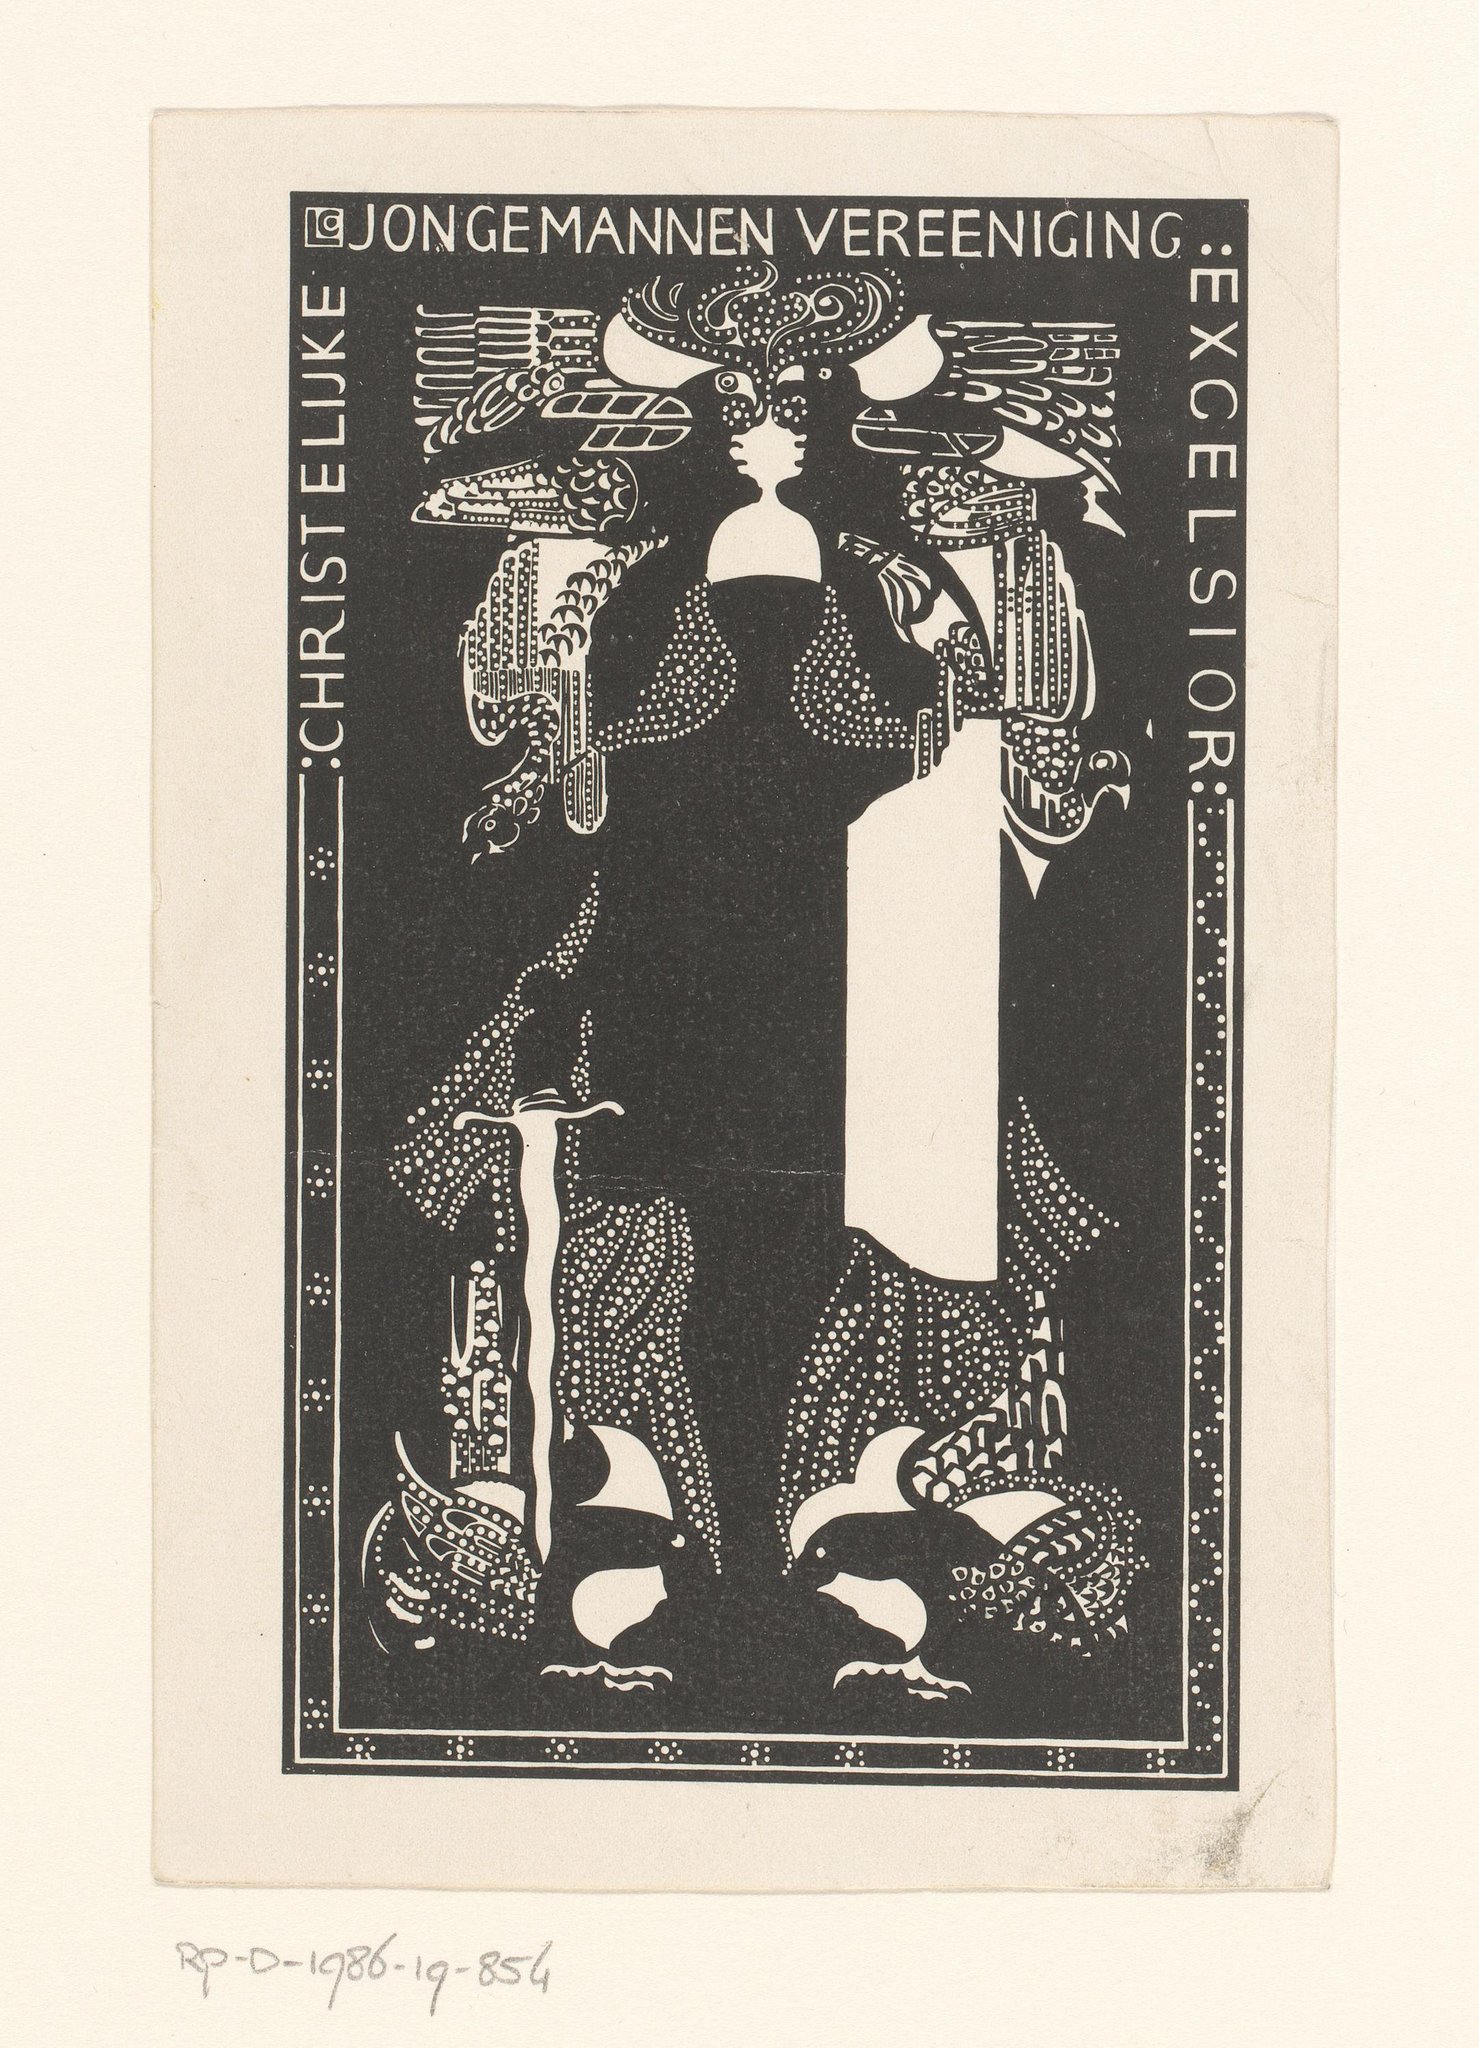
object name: bookplate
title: Ex libris van de Christelijke Jongemannen Vereeniging Excelsior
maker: carel adolph lion cachet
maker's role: draughtsman, print maker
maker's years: 1864-1945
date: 1916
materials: paper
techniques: printing block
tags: helmet, hacking and thrusting weapons: sword